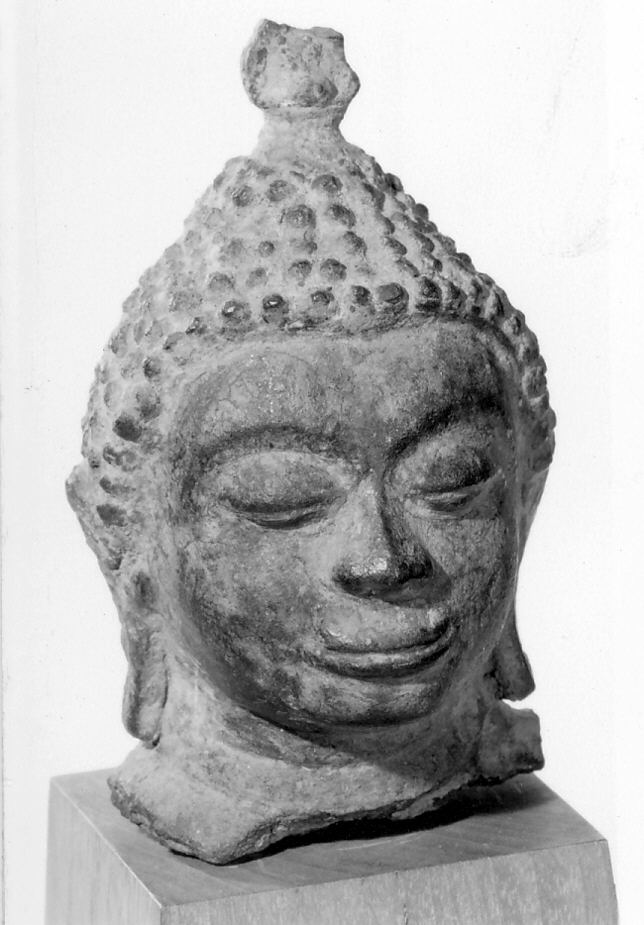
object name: head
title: Head of Buddha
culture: thai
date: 1301-1400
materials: bronze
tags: faces,heads,buddha